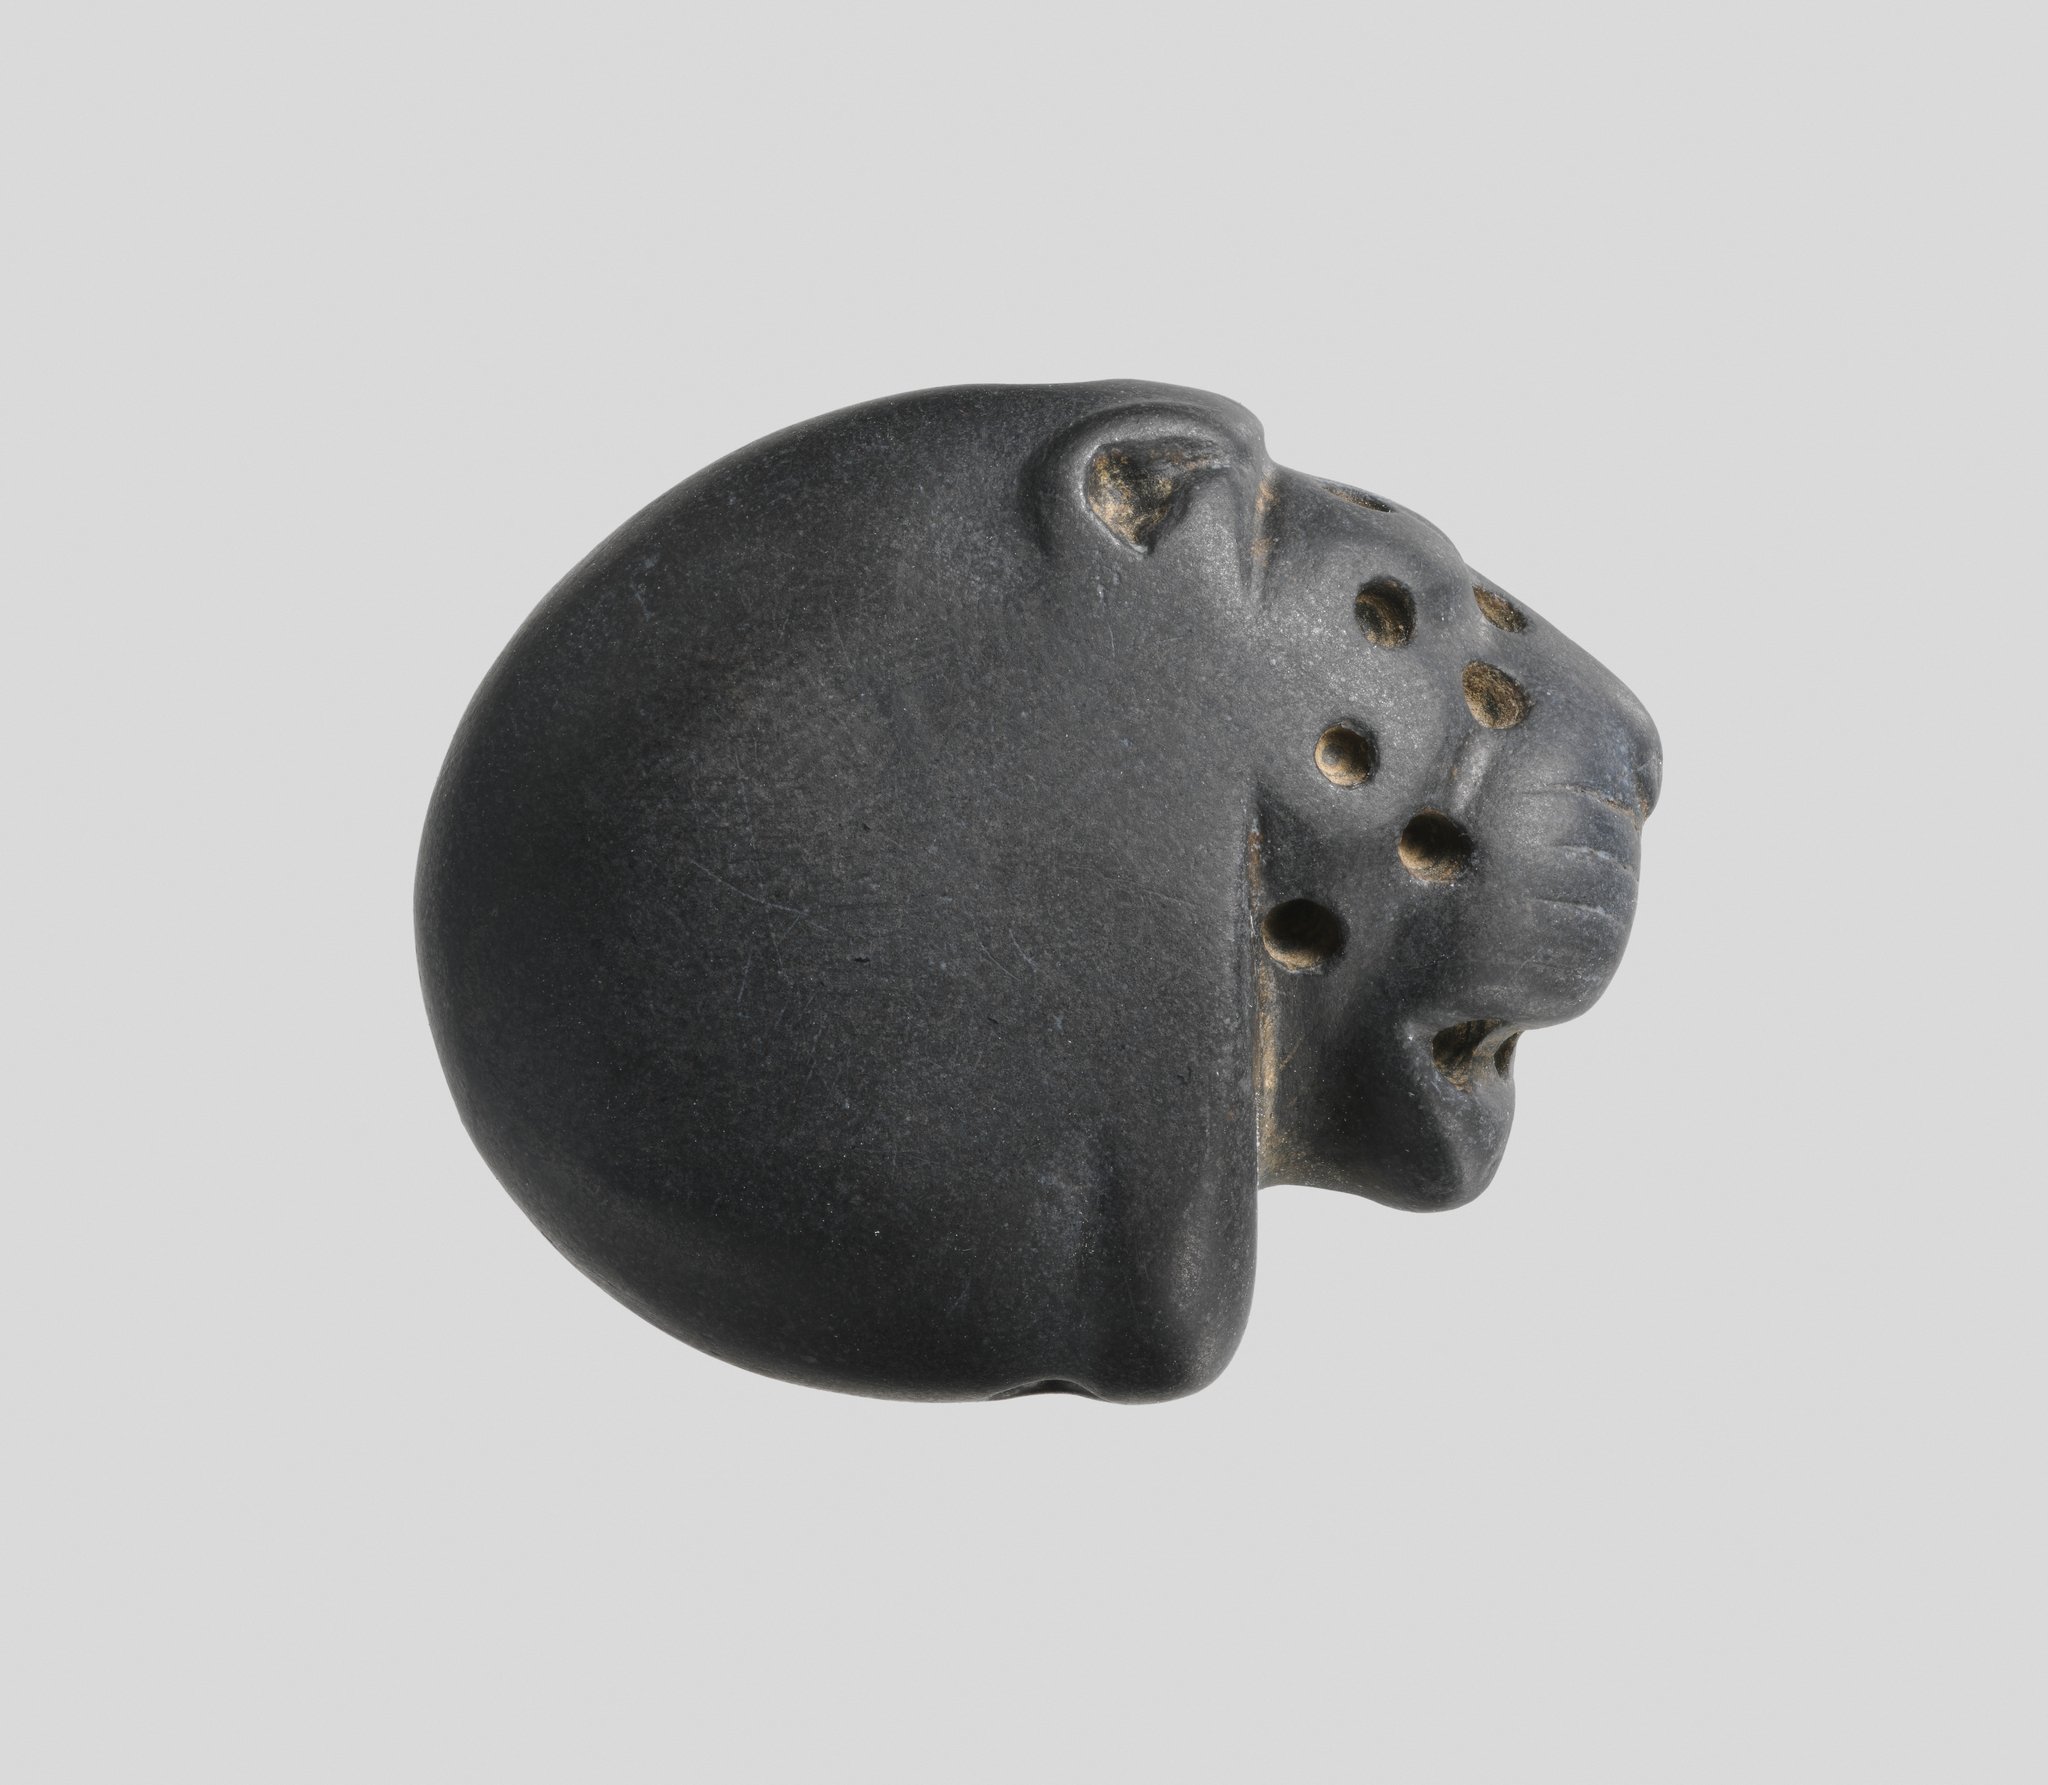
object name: stamp seal amulet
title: Seal amulet in the form of a lion's head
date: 3300-2900 BCE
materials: marble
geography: southern mesopotamia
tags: lions